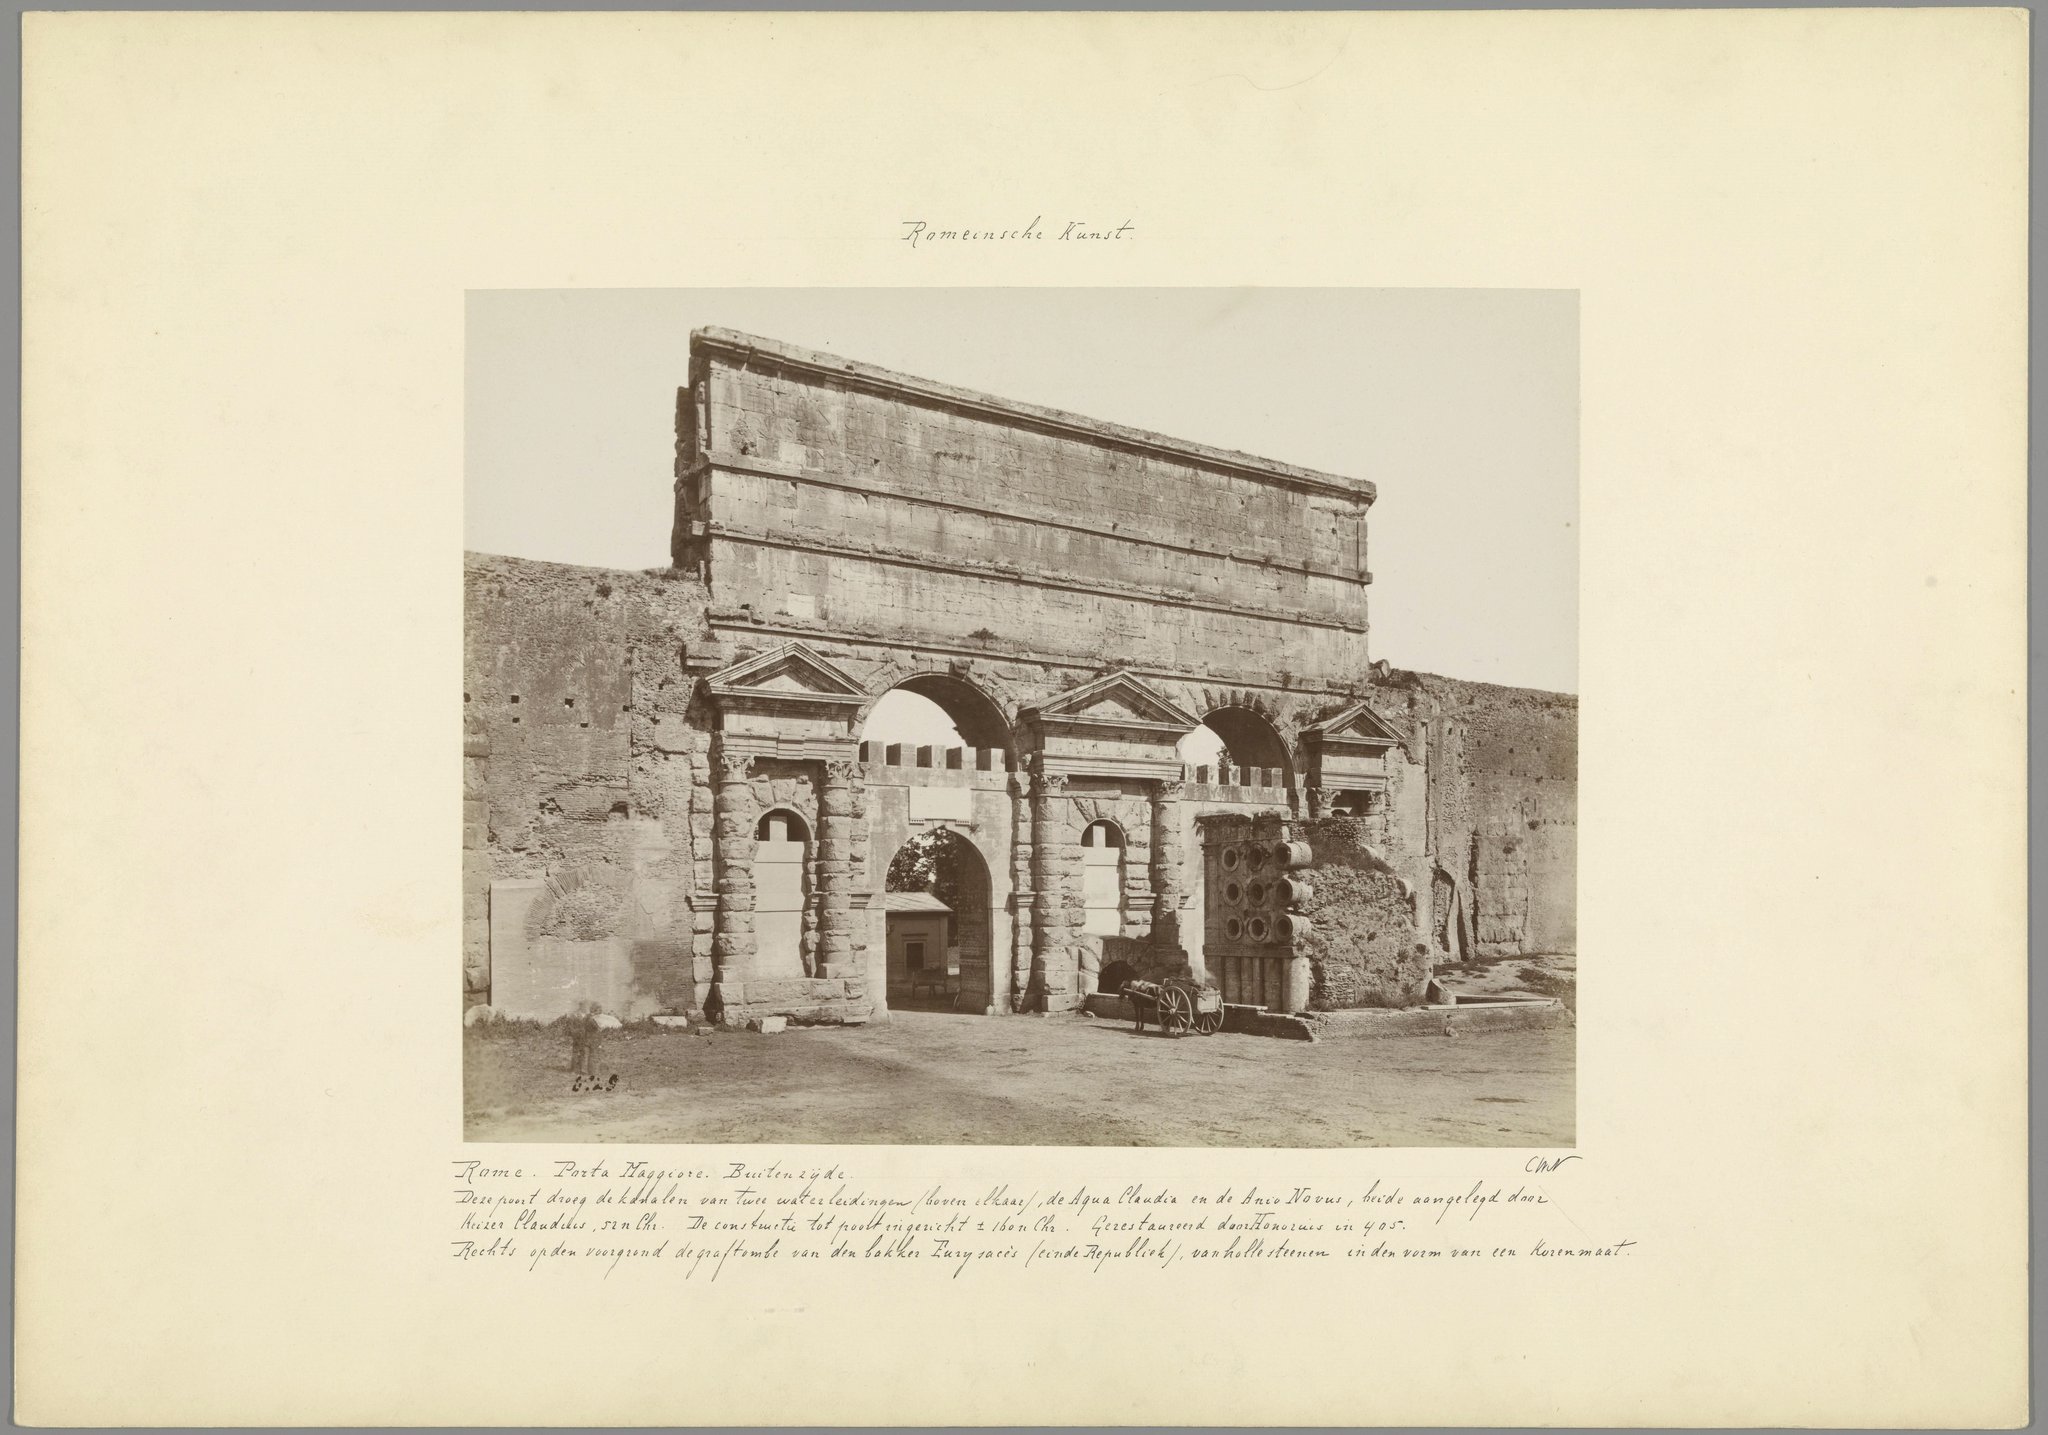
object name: photograph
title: Twee sculpturen van apostelen, afkomstig van de Sainte-Chapelle te Parijs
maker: Anonymous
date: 1875-1900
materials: cardboard, photographic support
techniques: albumen print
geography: palais du trocadéro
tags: (single) apostle, unspecified, sculpture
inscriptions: inscription: ‘MONUMENTS HISTORIQUES’, inscription: ‘Gothische Kunst - Frankrijk. De ,,Sainte-Chapelle'' te Parijs (...) de andere apostelfiguren zijn modern.’, collector's mark: ‘INSTITUUT VOOR KUNST- NIJVERHEIDSONDERWIJS GABRIËL METSUSTRAAT No. 16. AMSTERDAM’, collector's mark: ‘KUNSTNIJVERHEIDSCHOOL QUELLINUS AMSTERDAM FRANS HALSSTRAAT 14.’, inscription: ‘CWN.’